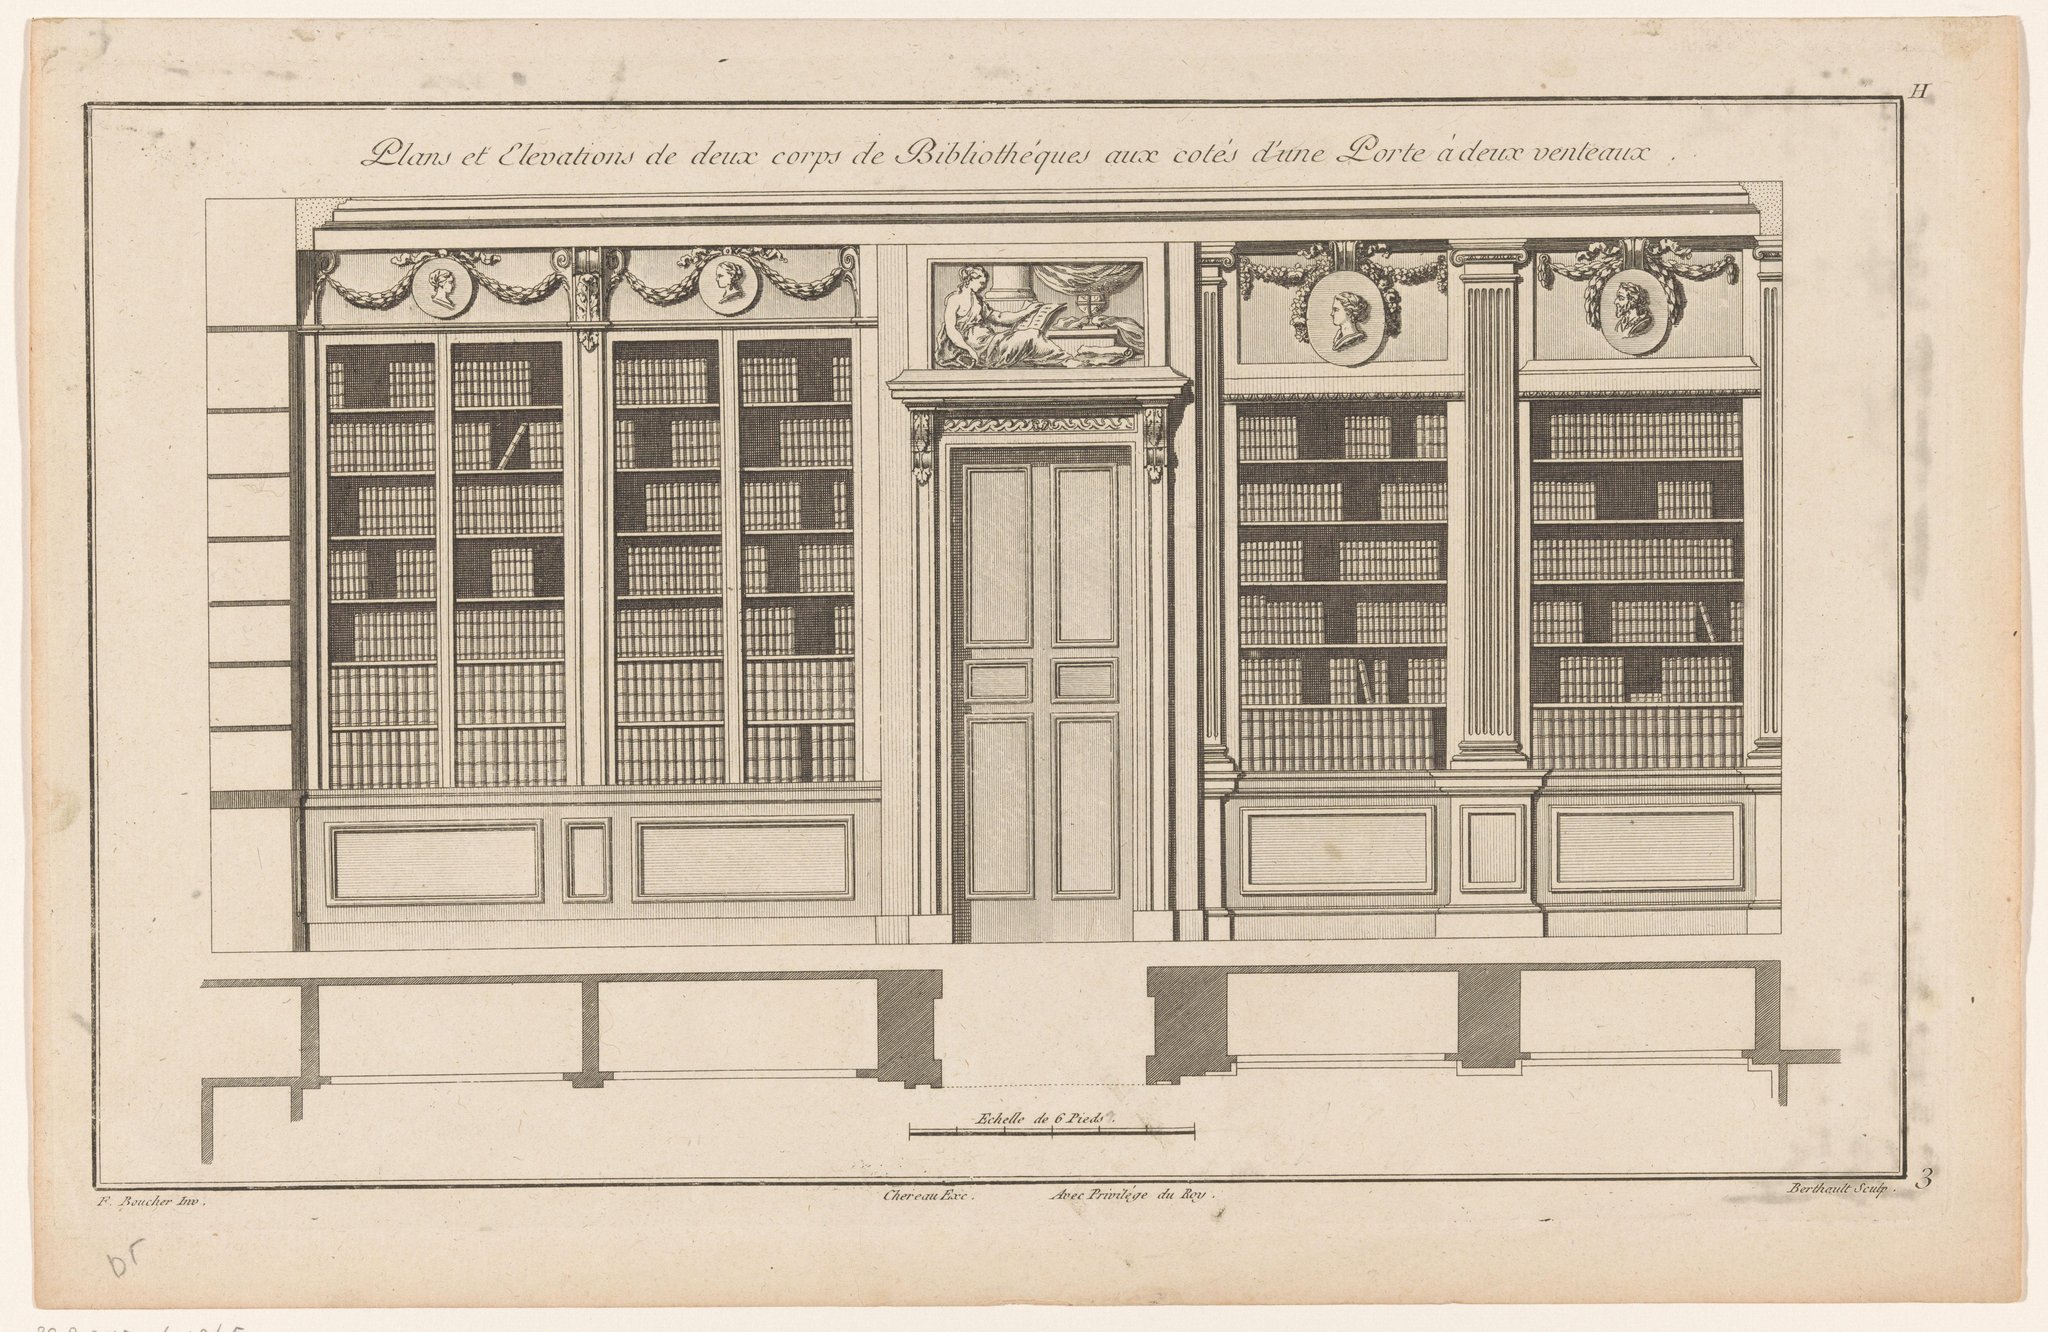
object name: ornament print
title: H Boekenkasten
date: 1752-1794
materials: paper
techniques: engraving, etching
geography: paris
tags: bookshelves, reading, ornament ~ medallion, door, ornament ~ festoon, garland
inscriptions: collector's mark: Lugt 4780, collector's mark: Lugt 2228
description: Ontwerp en plattegrond van twee boekenkasten aan weerszijden van een deur met dessus-de-porte met een lezende vrouw. Boven de kasten panelen met guirlandes en portretten en profil in medaillons.